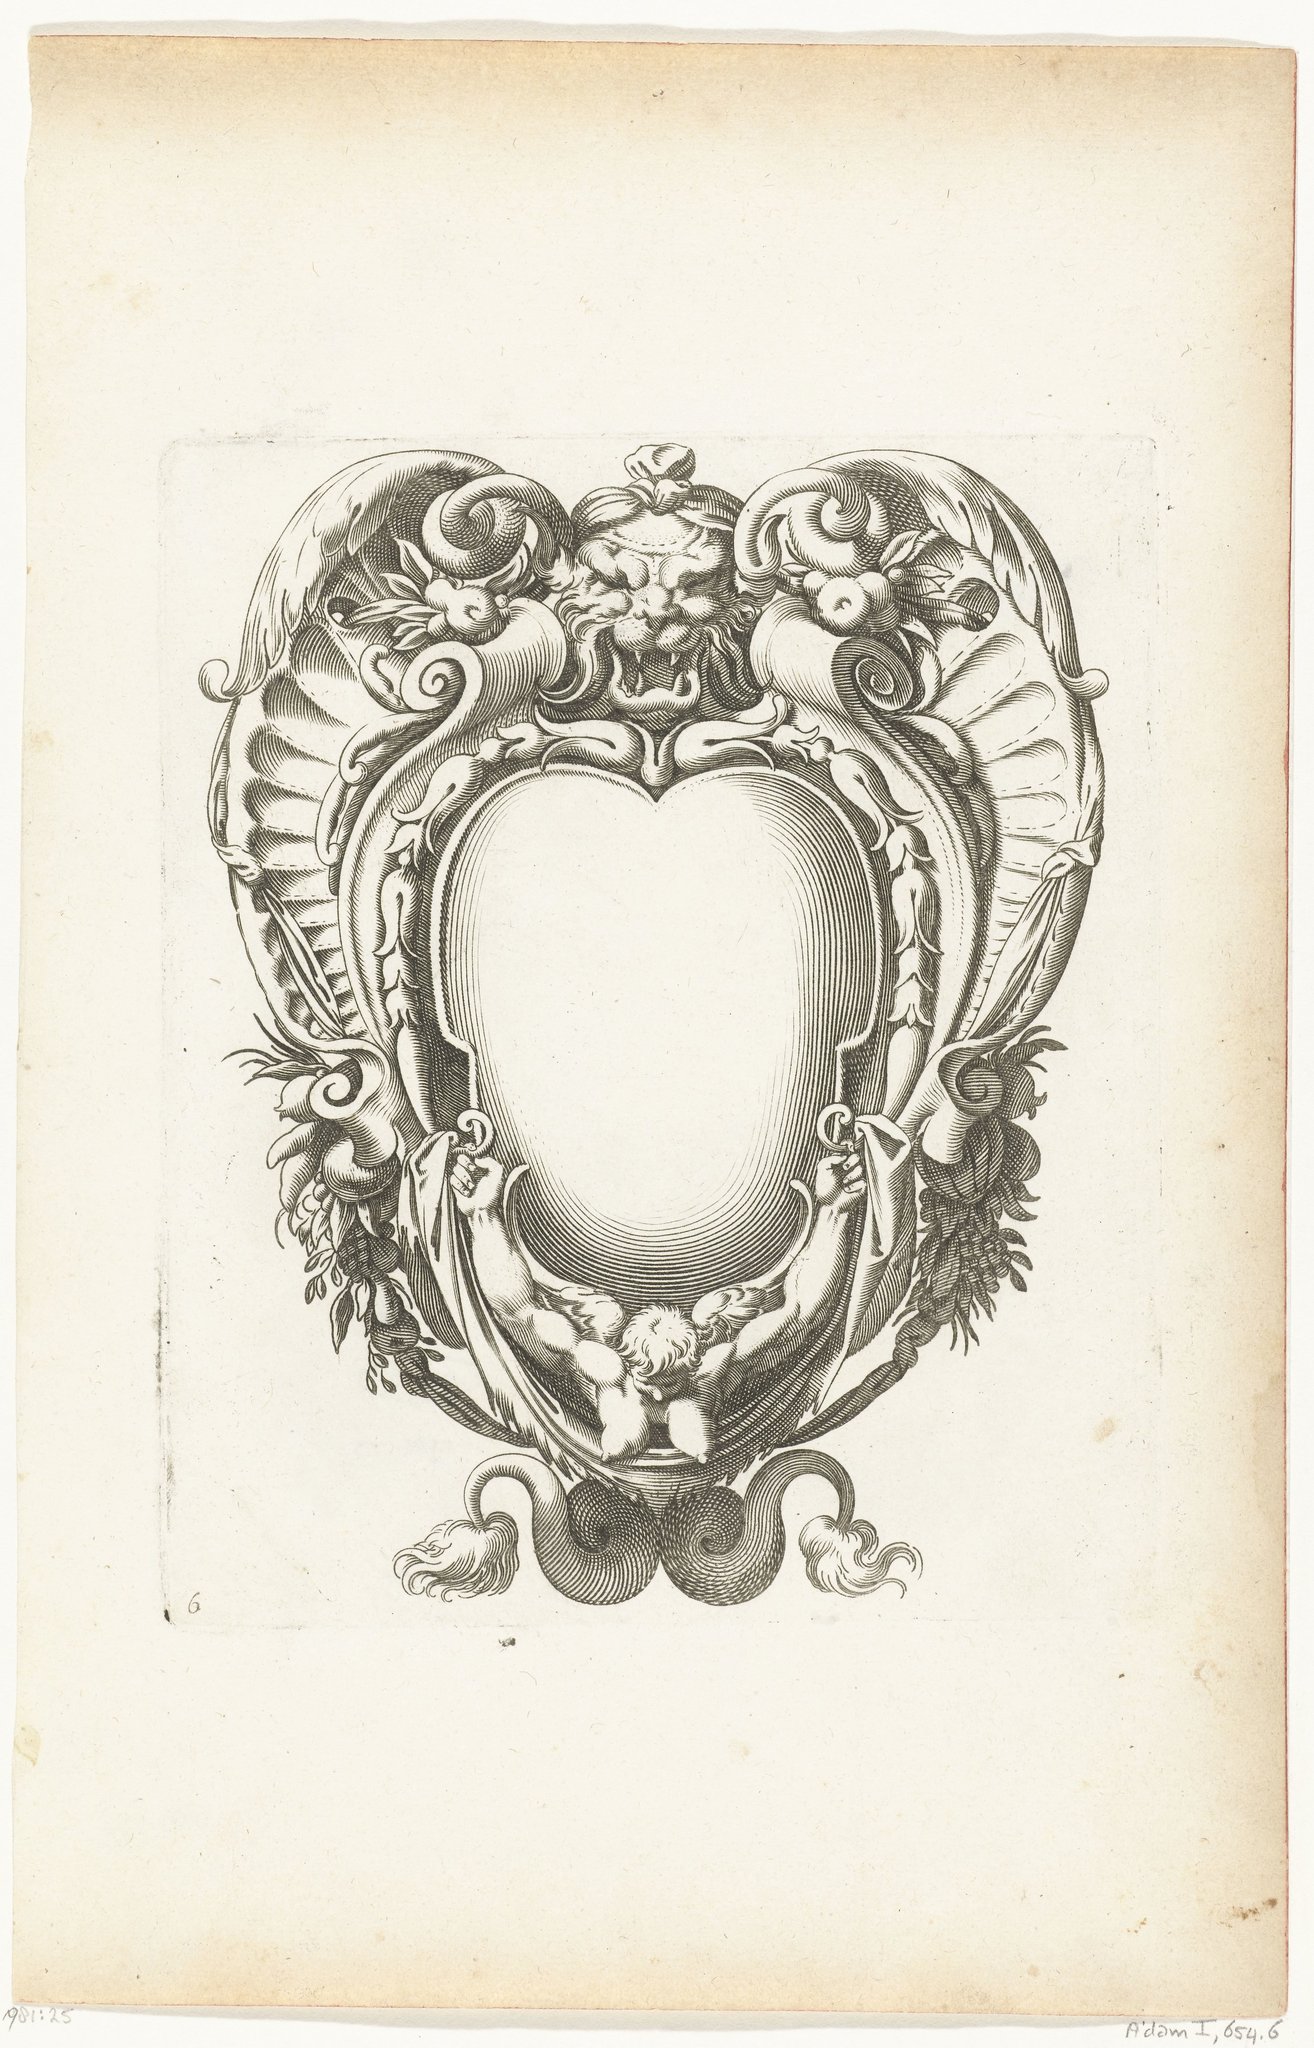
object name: ornament print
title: Cartouches in omlijstingen van rolwerk met grotesken, guirlandes en mascarons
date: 1613-1657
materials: paper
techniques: engraving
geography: france